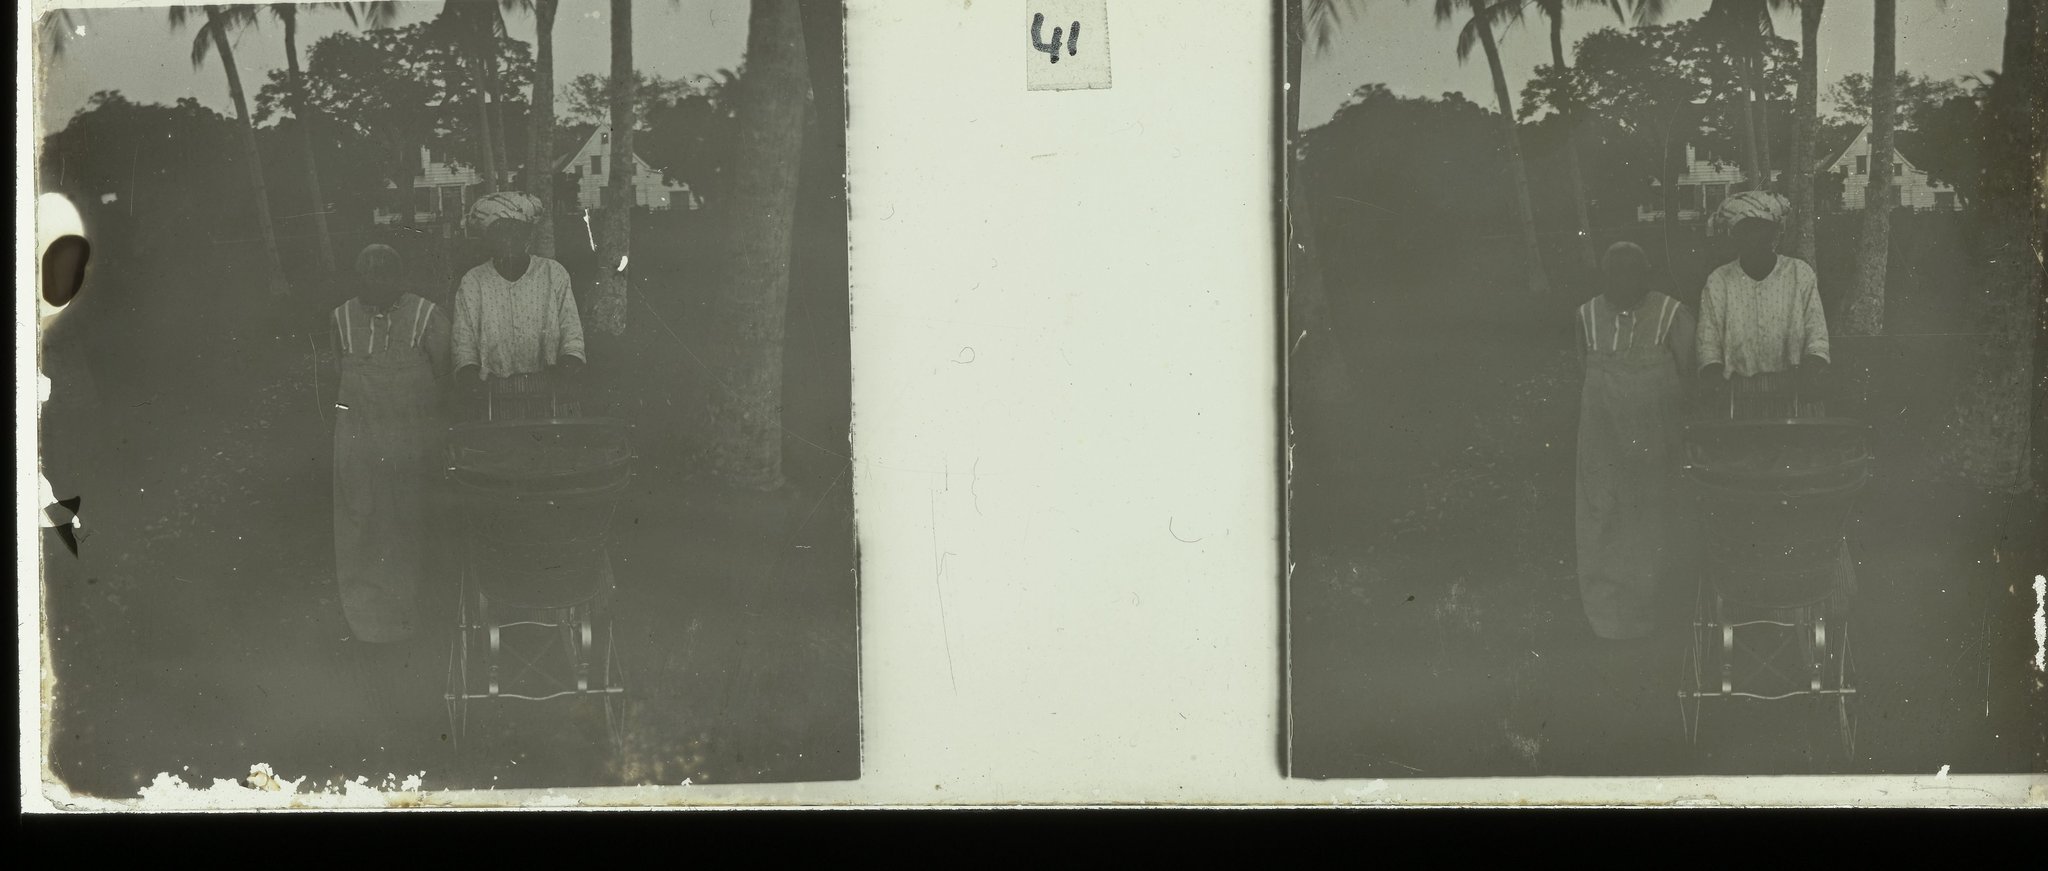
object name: stereograph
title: Dienstmeisje met kinderwagen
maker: theodoor brouwers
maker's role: amateurfotograaf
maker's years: 1874-1932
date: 1913-1930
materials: glass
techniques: photography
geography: suriname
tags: amsterdam, theodoor brouwers, suriname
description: In de periode 1911-1932 woonde op plantage Accaribo in Suriname de familie Brouwers van wie de foto's afkomstig zijn. Rond 1910 vond Theodoor Brouwers werk op plantage Accaribo. In 1929 werd hij eigenaar van de plantage. Op Accaribo werden in zijn tijd bananen geproduceerd en wat koffie.